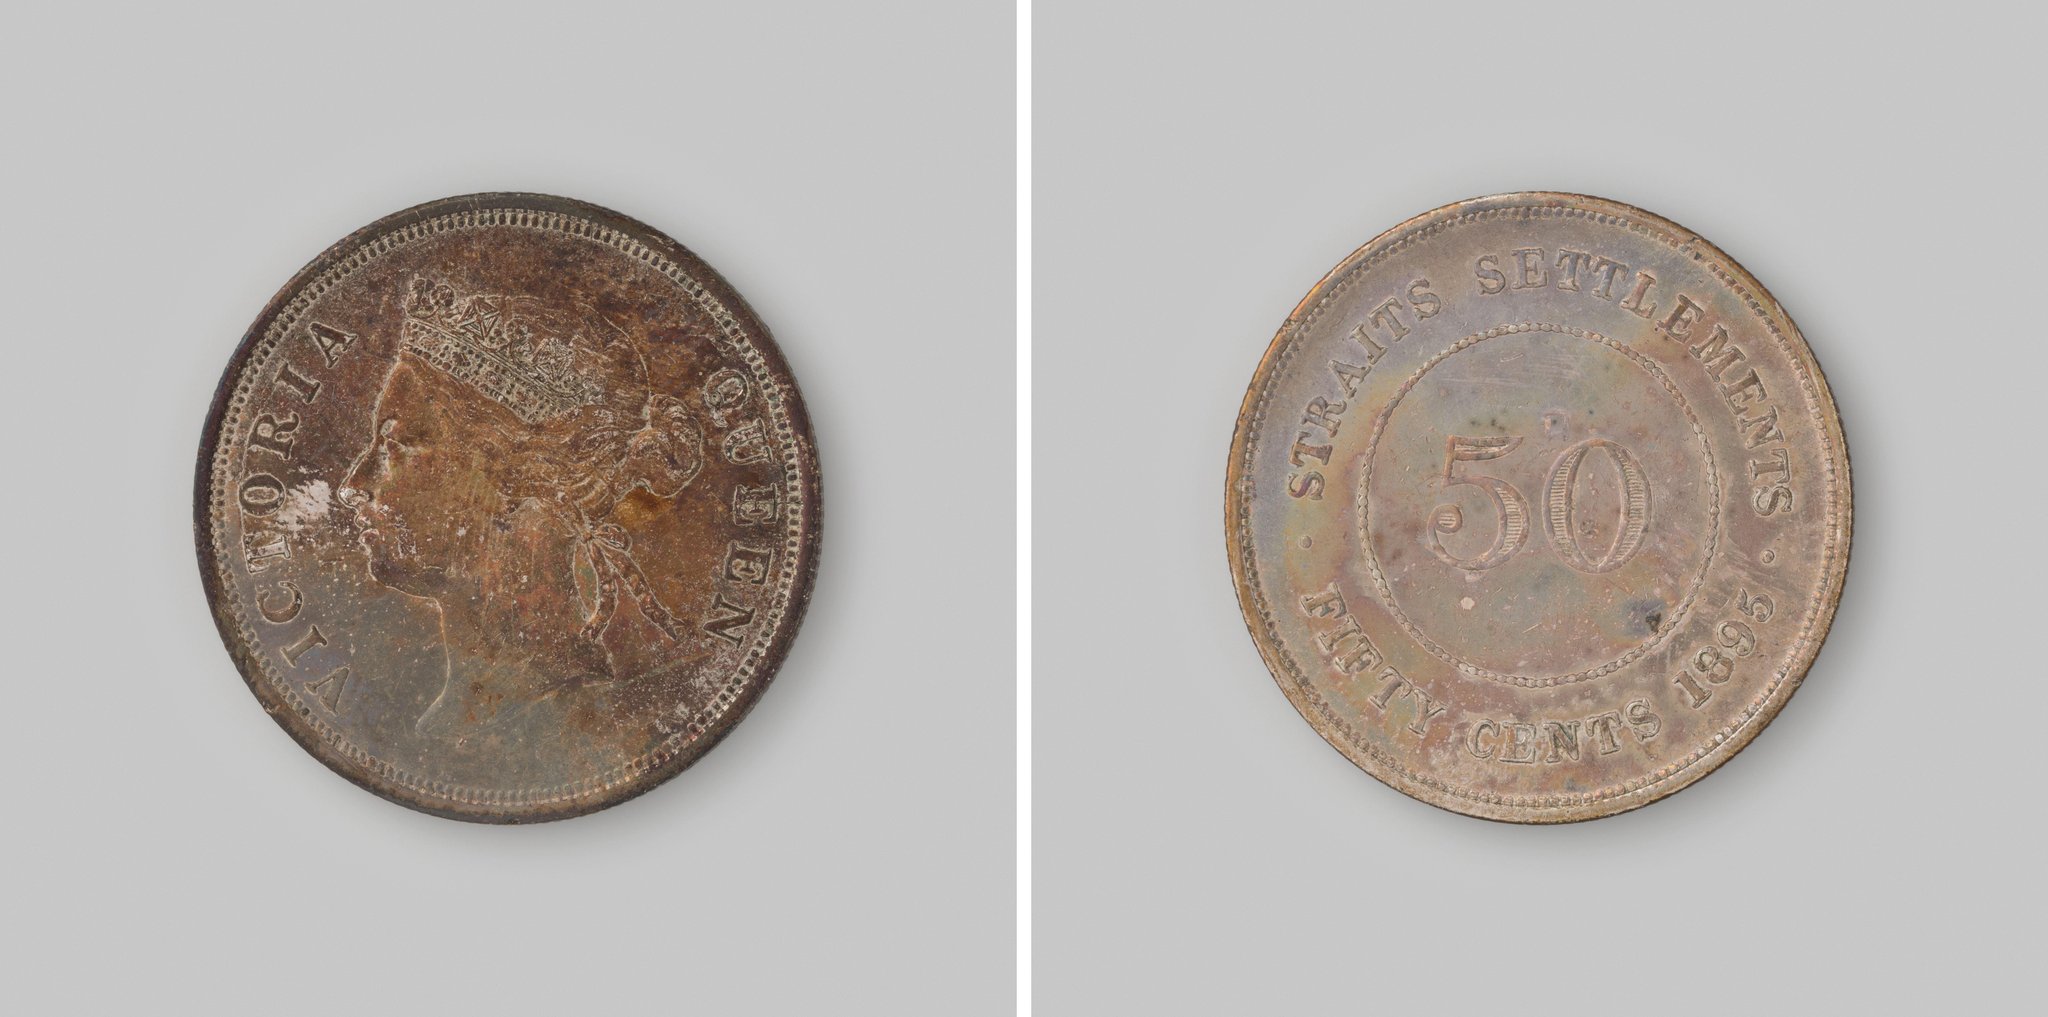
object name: coin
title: 50 cents uit de Straits Settlements van koningin Victoria, 1895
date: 1895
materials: silver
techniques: striking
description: Zilveren munt. Voorzijde: gekroond hoofd van koningin Victoria naar links. Keerzijde: binnen parelcirkel waarde-aanduiding: 50. In omschrift onderaan waarde-aanduiding: fifty cents met rechts daarvan jaartal. Kartelrand.